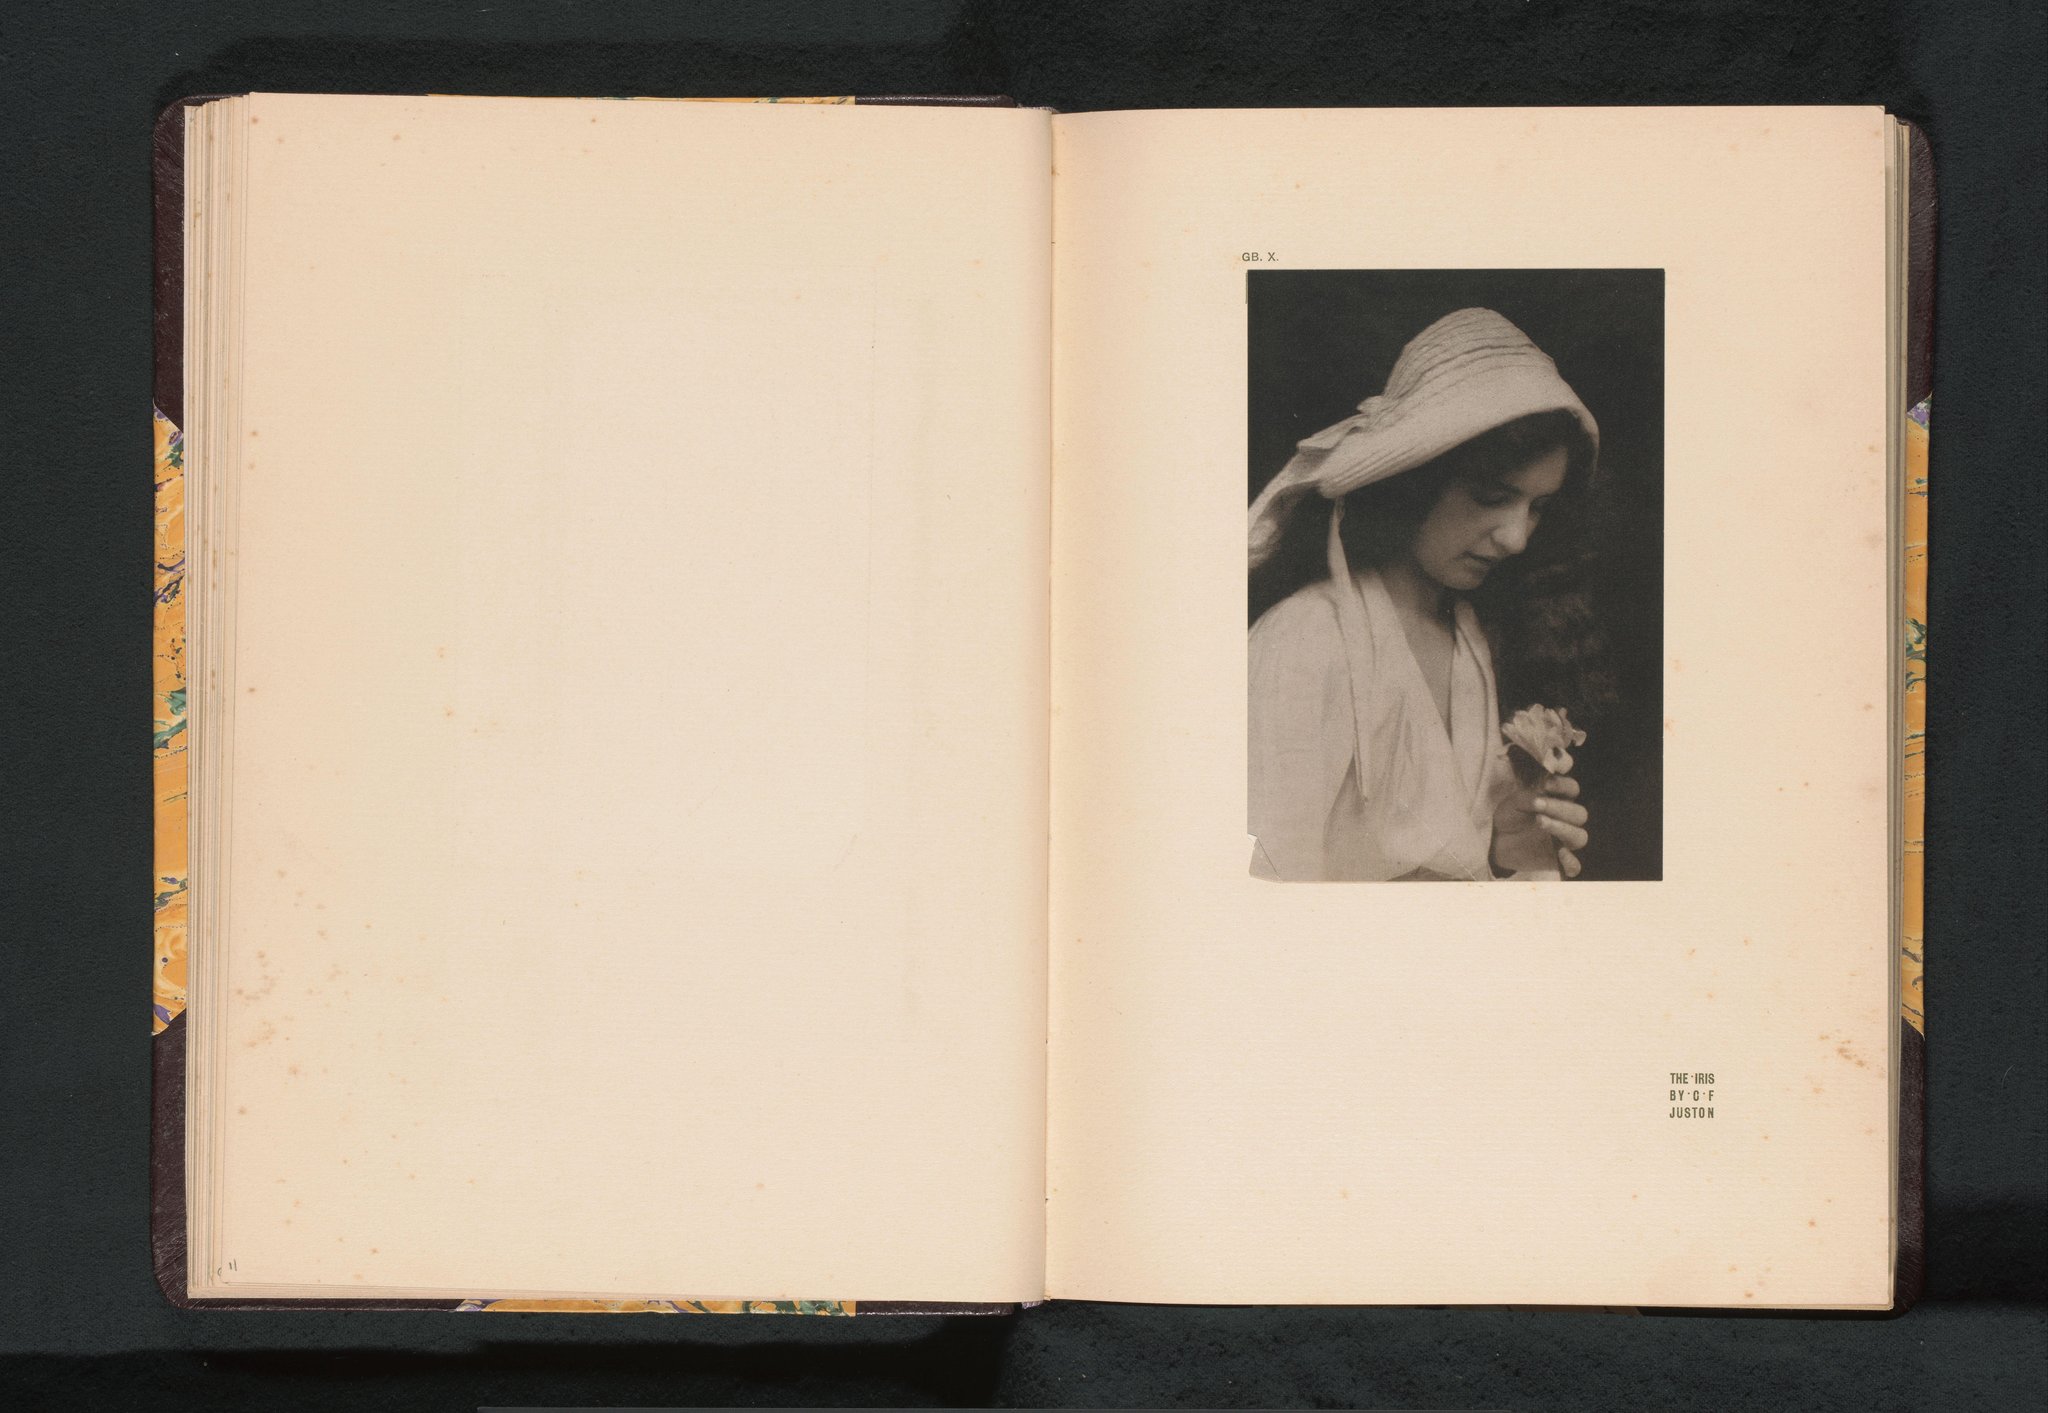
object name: page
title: Portret van een onbekende vrouw met een iris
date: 1900-1905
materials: paper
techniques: two-color autotype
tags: historical persons - bb - woman, flowers: iris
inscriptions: inscription: ‘The Iris by C.F. Juston’, inscription: ‘GB. X.’